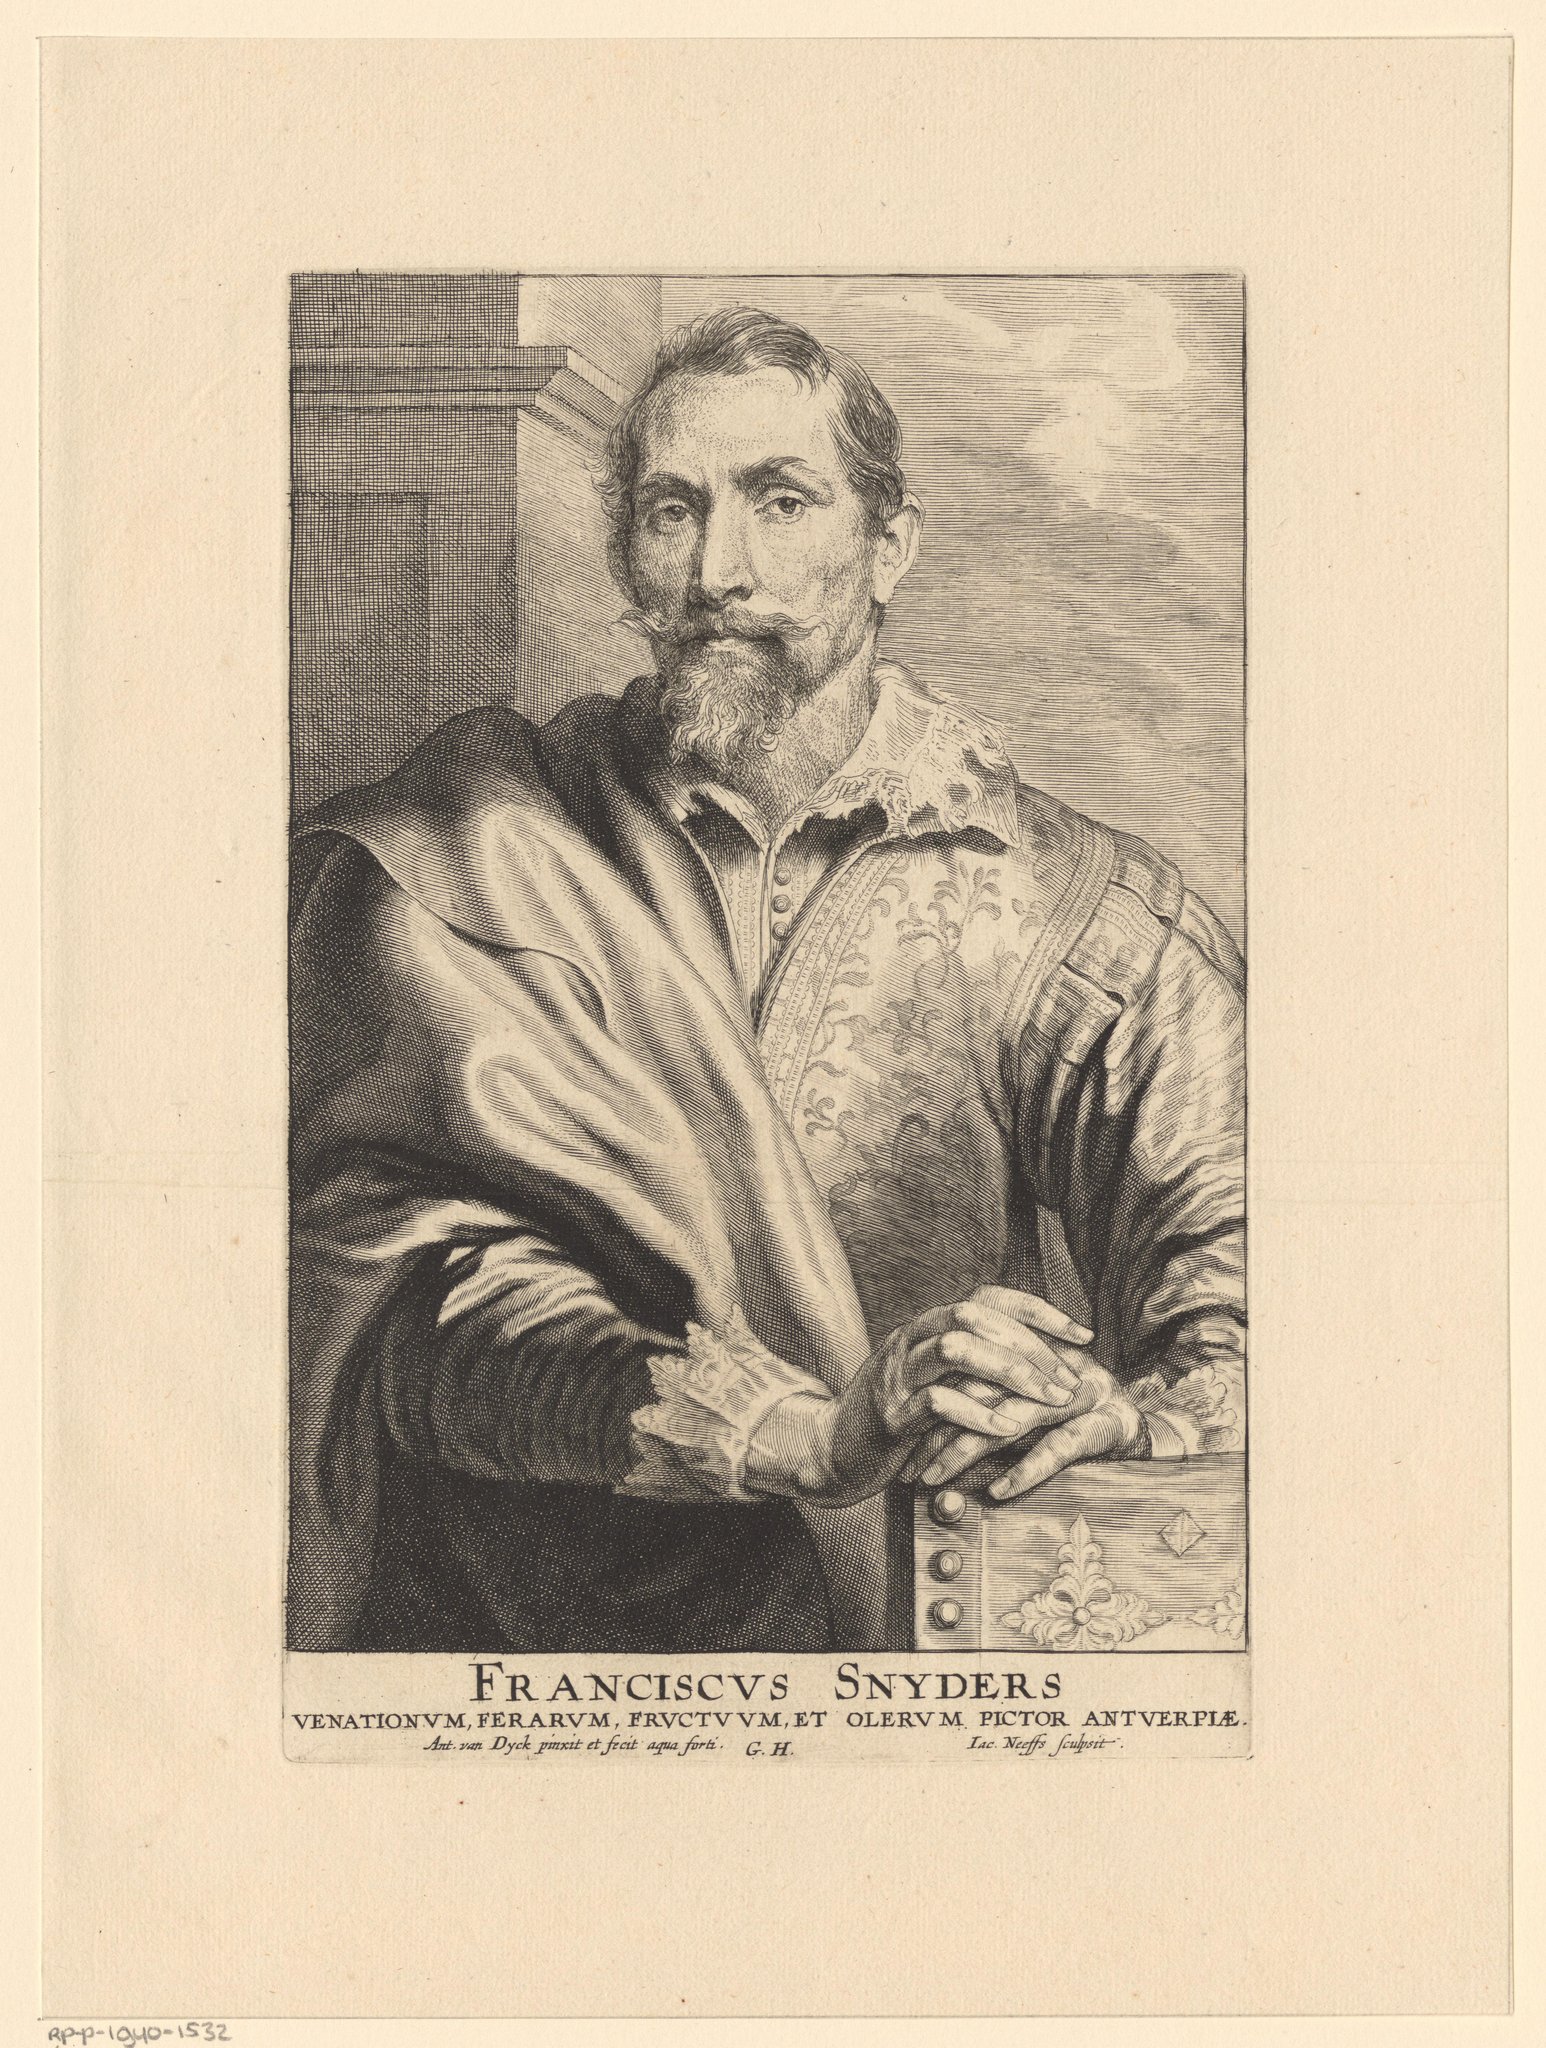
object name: print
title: Iconographie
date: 1630-1632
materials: paper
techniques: engraving, etching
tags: antwerp, painter, draughtsman, frans snijders, historical persons, portrait, self-portrait of artist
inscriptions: collector's mark: Lugt 2166, collector's mark: Lugt 2228, collector's mark: Lugt 2760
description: Met eenregelig onderschrift in het Latijn.